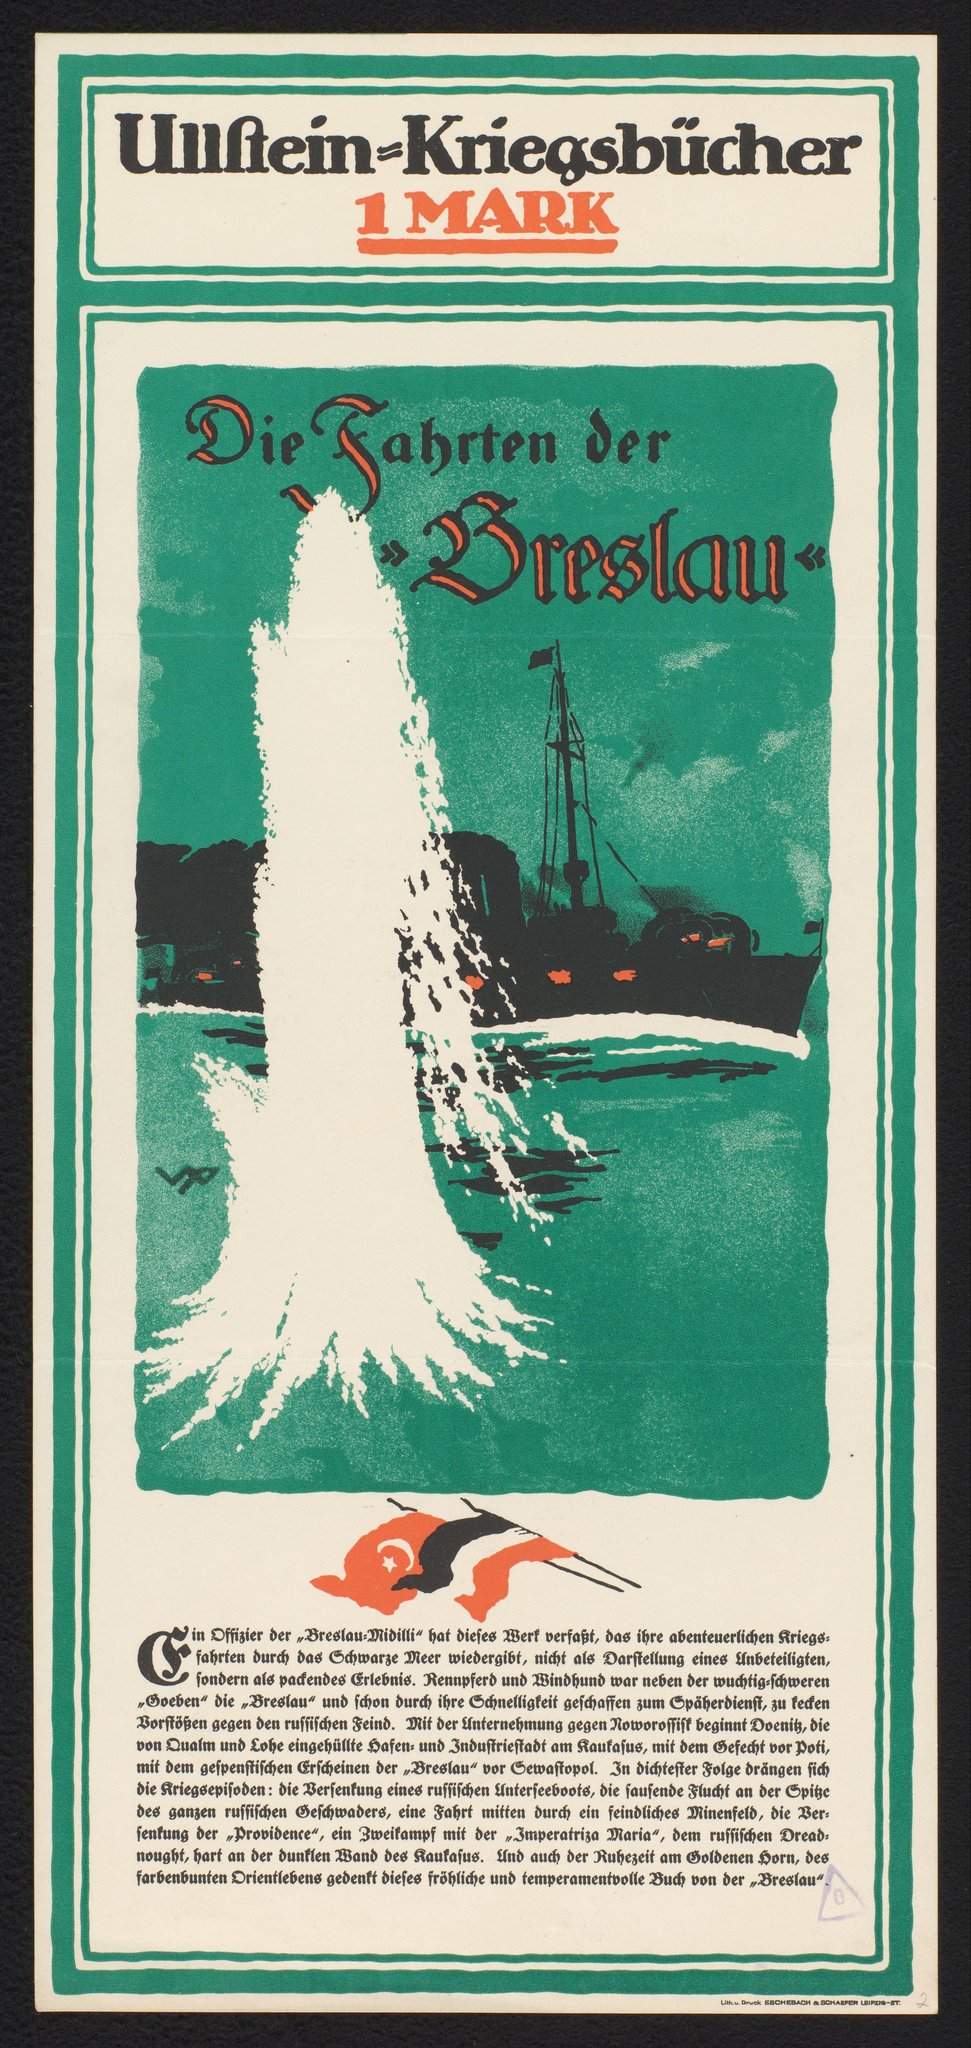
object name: print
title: Reclamebiljet voor: Karl Dönitz, Die Fahrten der 'Breslau' im Schwarzen Meer, 1917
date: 1917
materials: paper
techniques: lithograph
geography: berlin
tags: steamship, motorship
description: Reclamebiljet ter promotie van: Dönitz, Karl. Die Fahrten der 'Breslau' im Schwarzen Meer. Berlijn: Ullstein, 1917. Deel 28 uit de serie 'Ullstein-Kriegsbücher'.